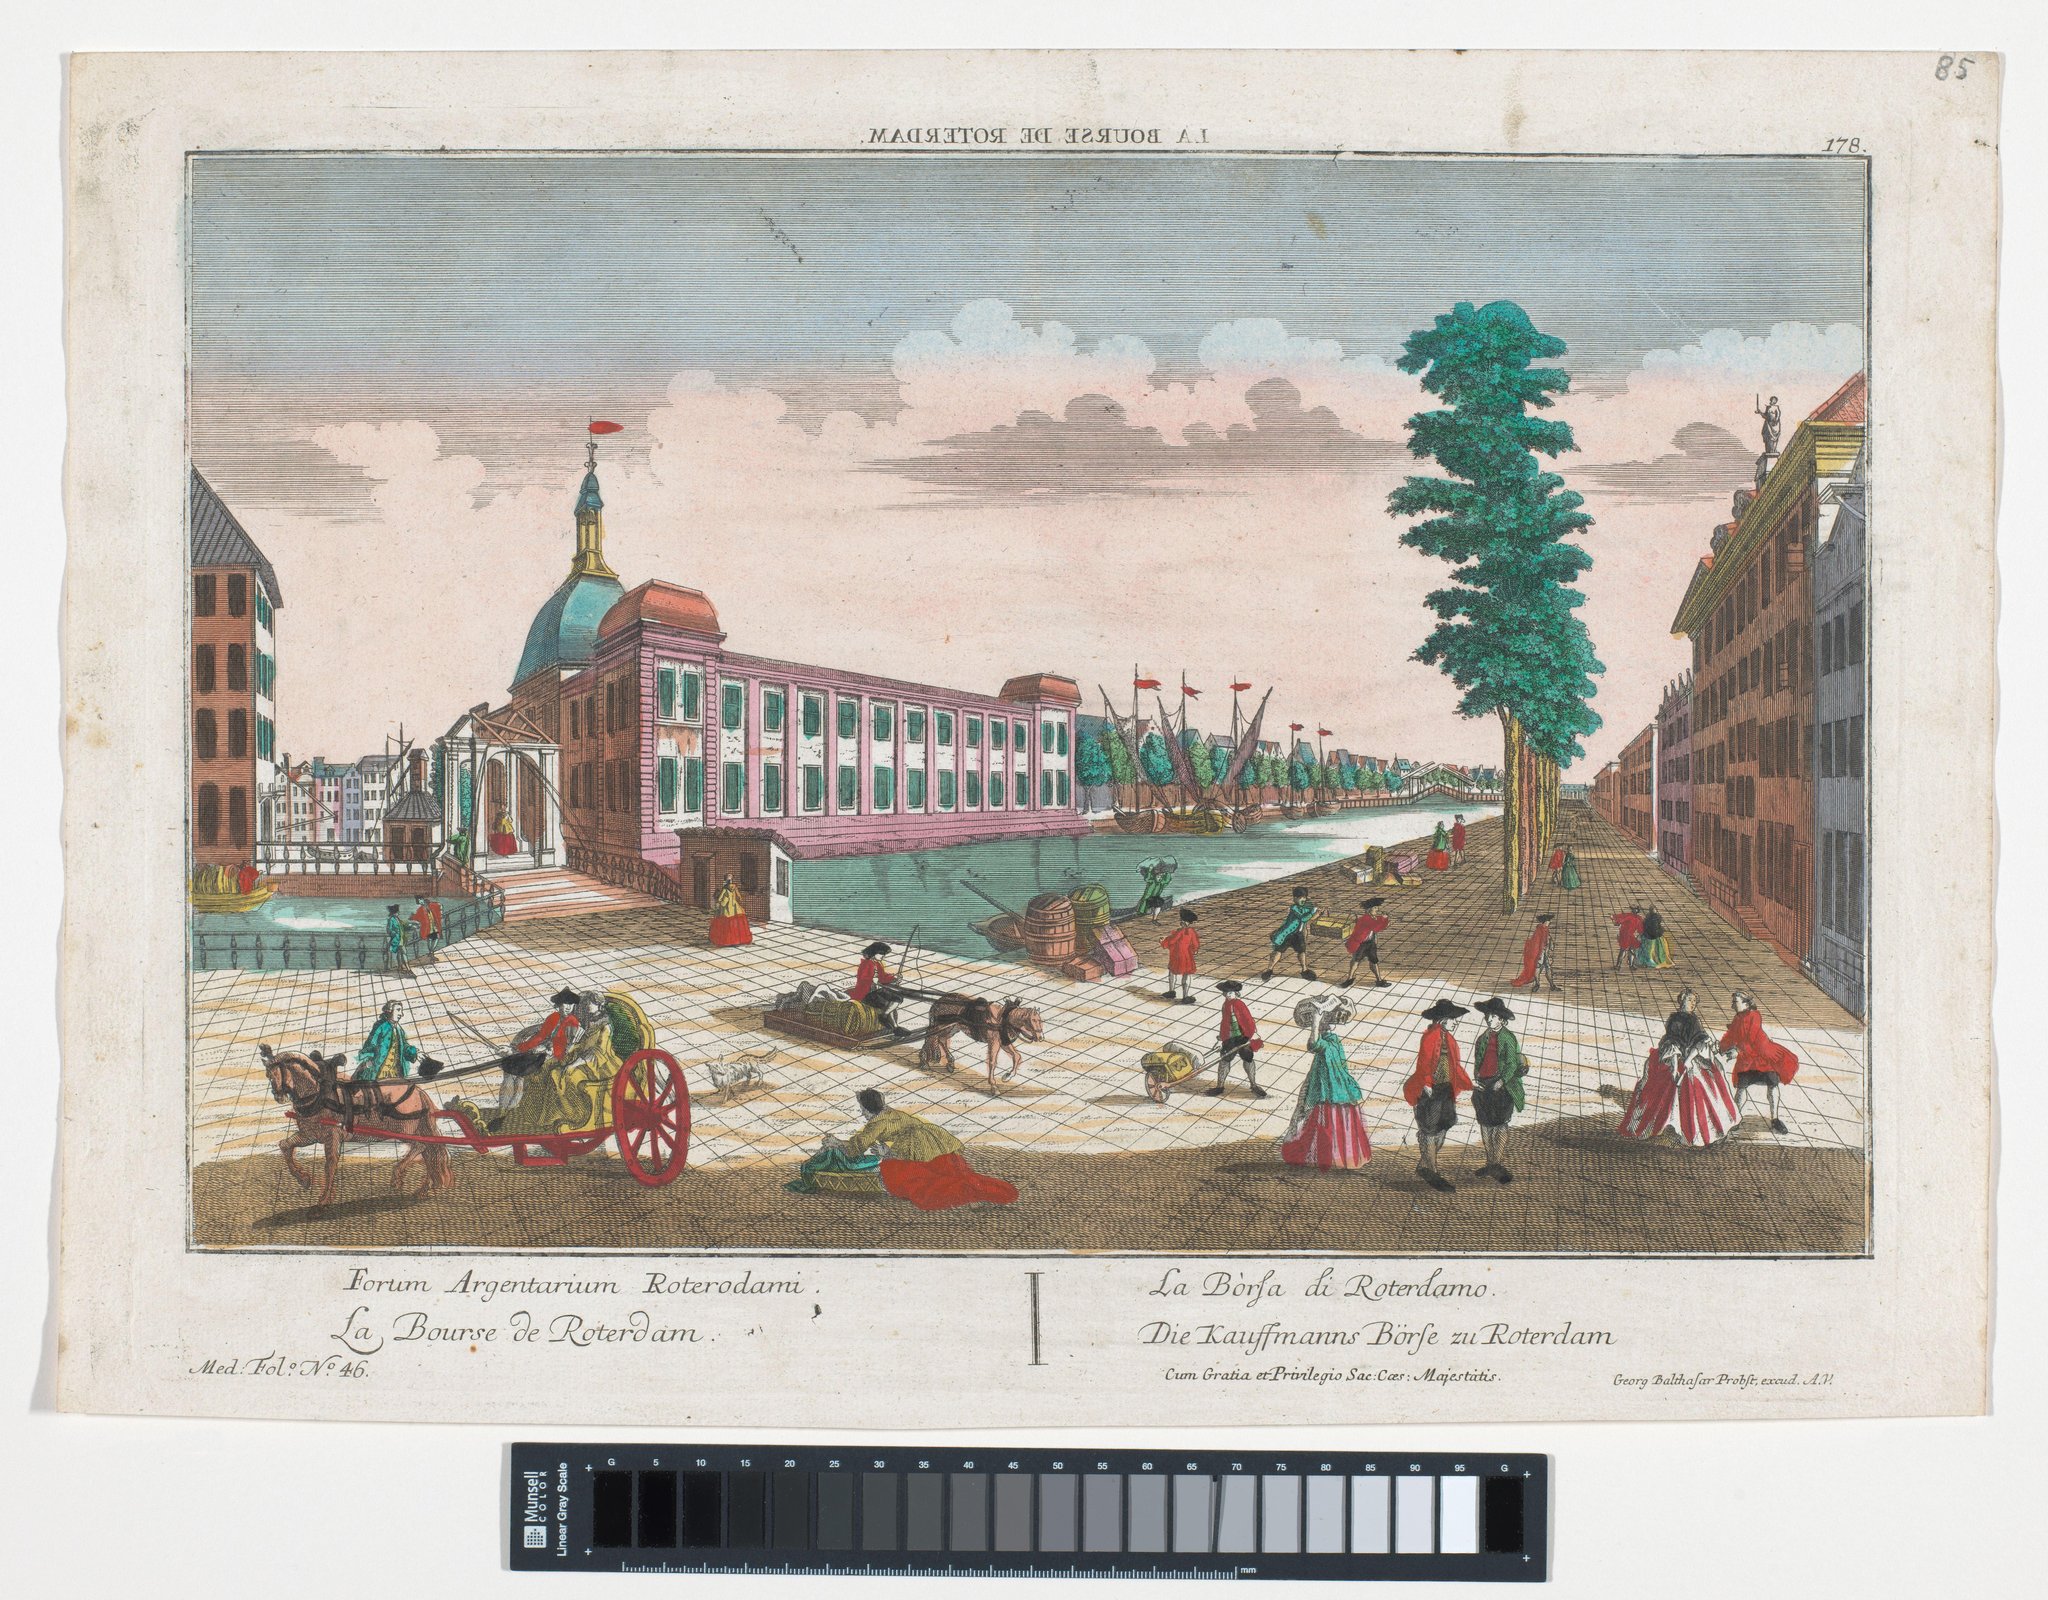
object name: print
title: Rotterdam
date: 1742-1801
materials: paper, watercolor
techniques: brush, etching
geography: germany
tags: bridge in city across river, canal, etc. (+ city(-scape) with figures, staffage), stock exchange, stock-market, street (+ city(-scape) with figures, staffage)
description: De serie “Rotterdam”, met het nummer 46, bevat vier prenten met de nummers 177-180, waarvan dit nummer 178 is.